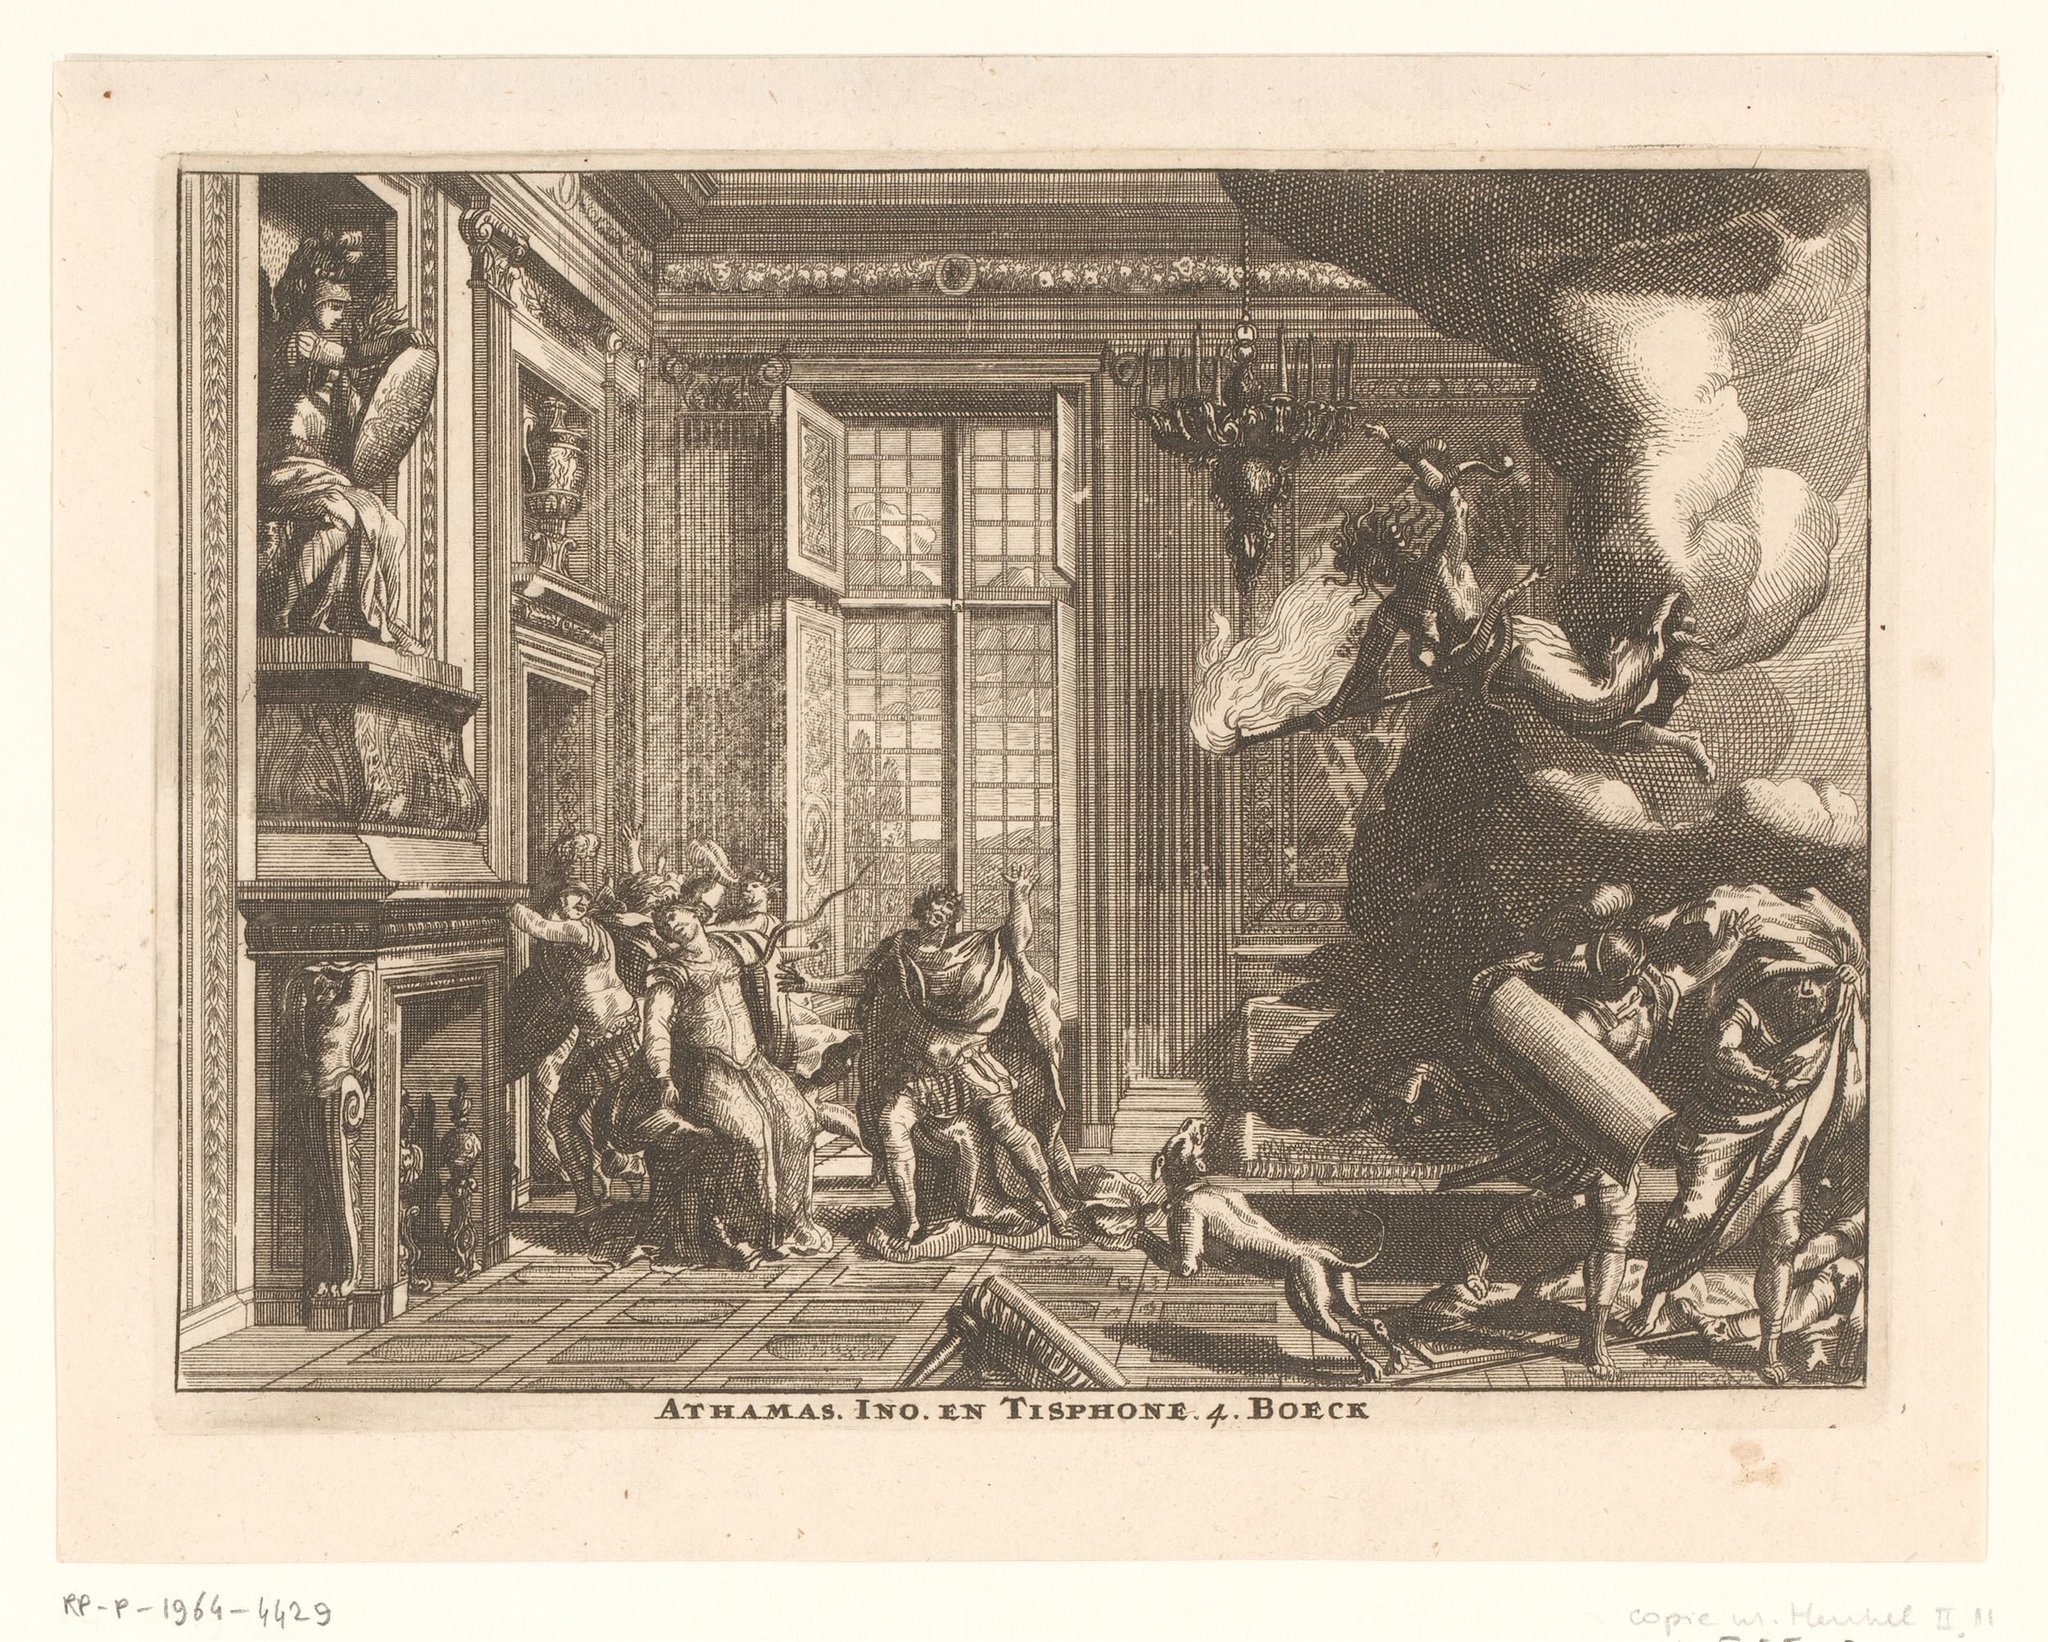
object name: print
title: Athamas. Ino. en Tisphone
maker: Anonymous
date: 1628-1682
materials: paper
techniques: etching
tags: alecto flings a snake from her hair into the bosom of latinus' wife amata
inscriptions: collector's mark: Lugt 2228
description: Lijkt deel uit te maken van een serie prenten met mythologische onderwerpen, naar prenten door Jean Lepautre en voorzien van Nederlandse titels. Mogelijk werd de serie uitgegeven door Cornelis (I) of Cornelis (II) Danckerts, zoals vermeld op RP-P-1964-4431 en RP-P-1964-4443.